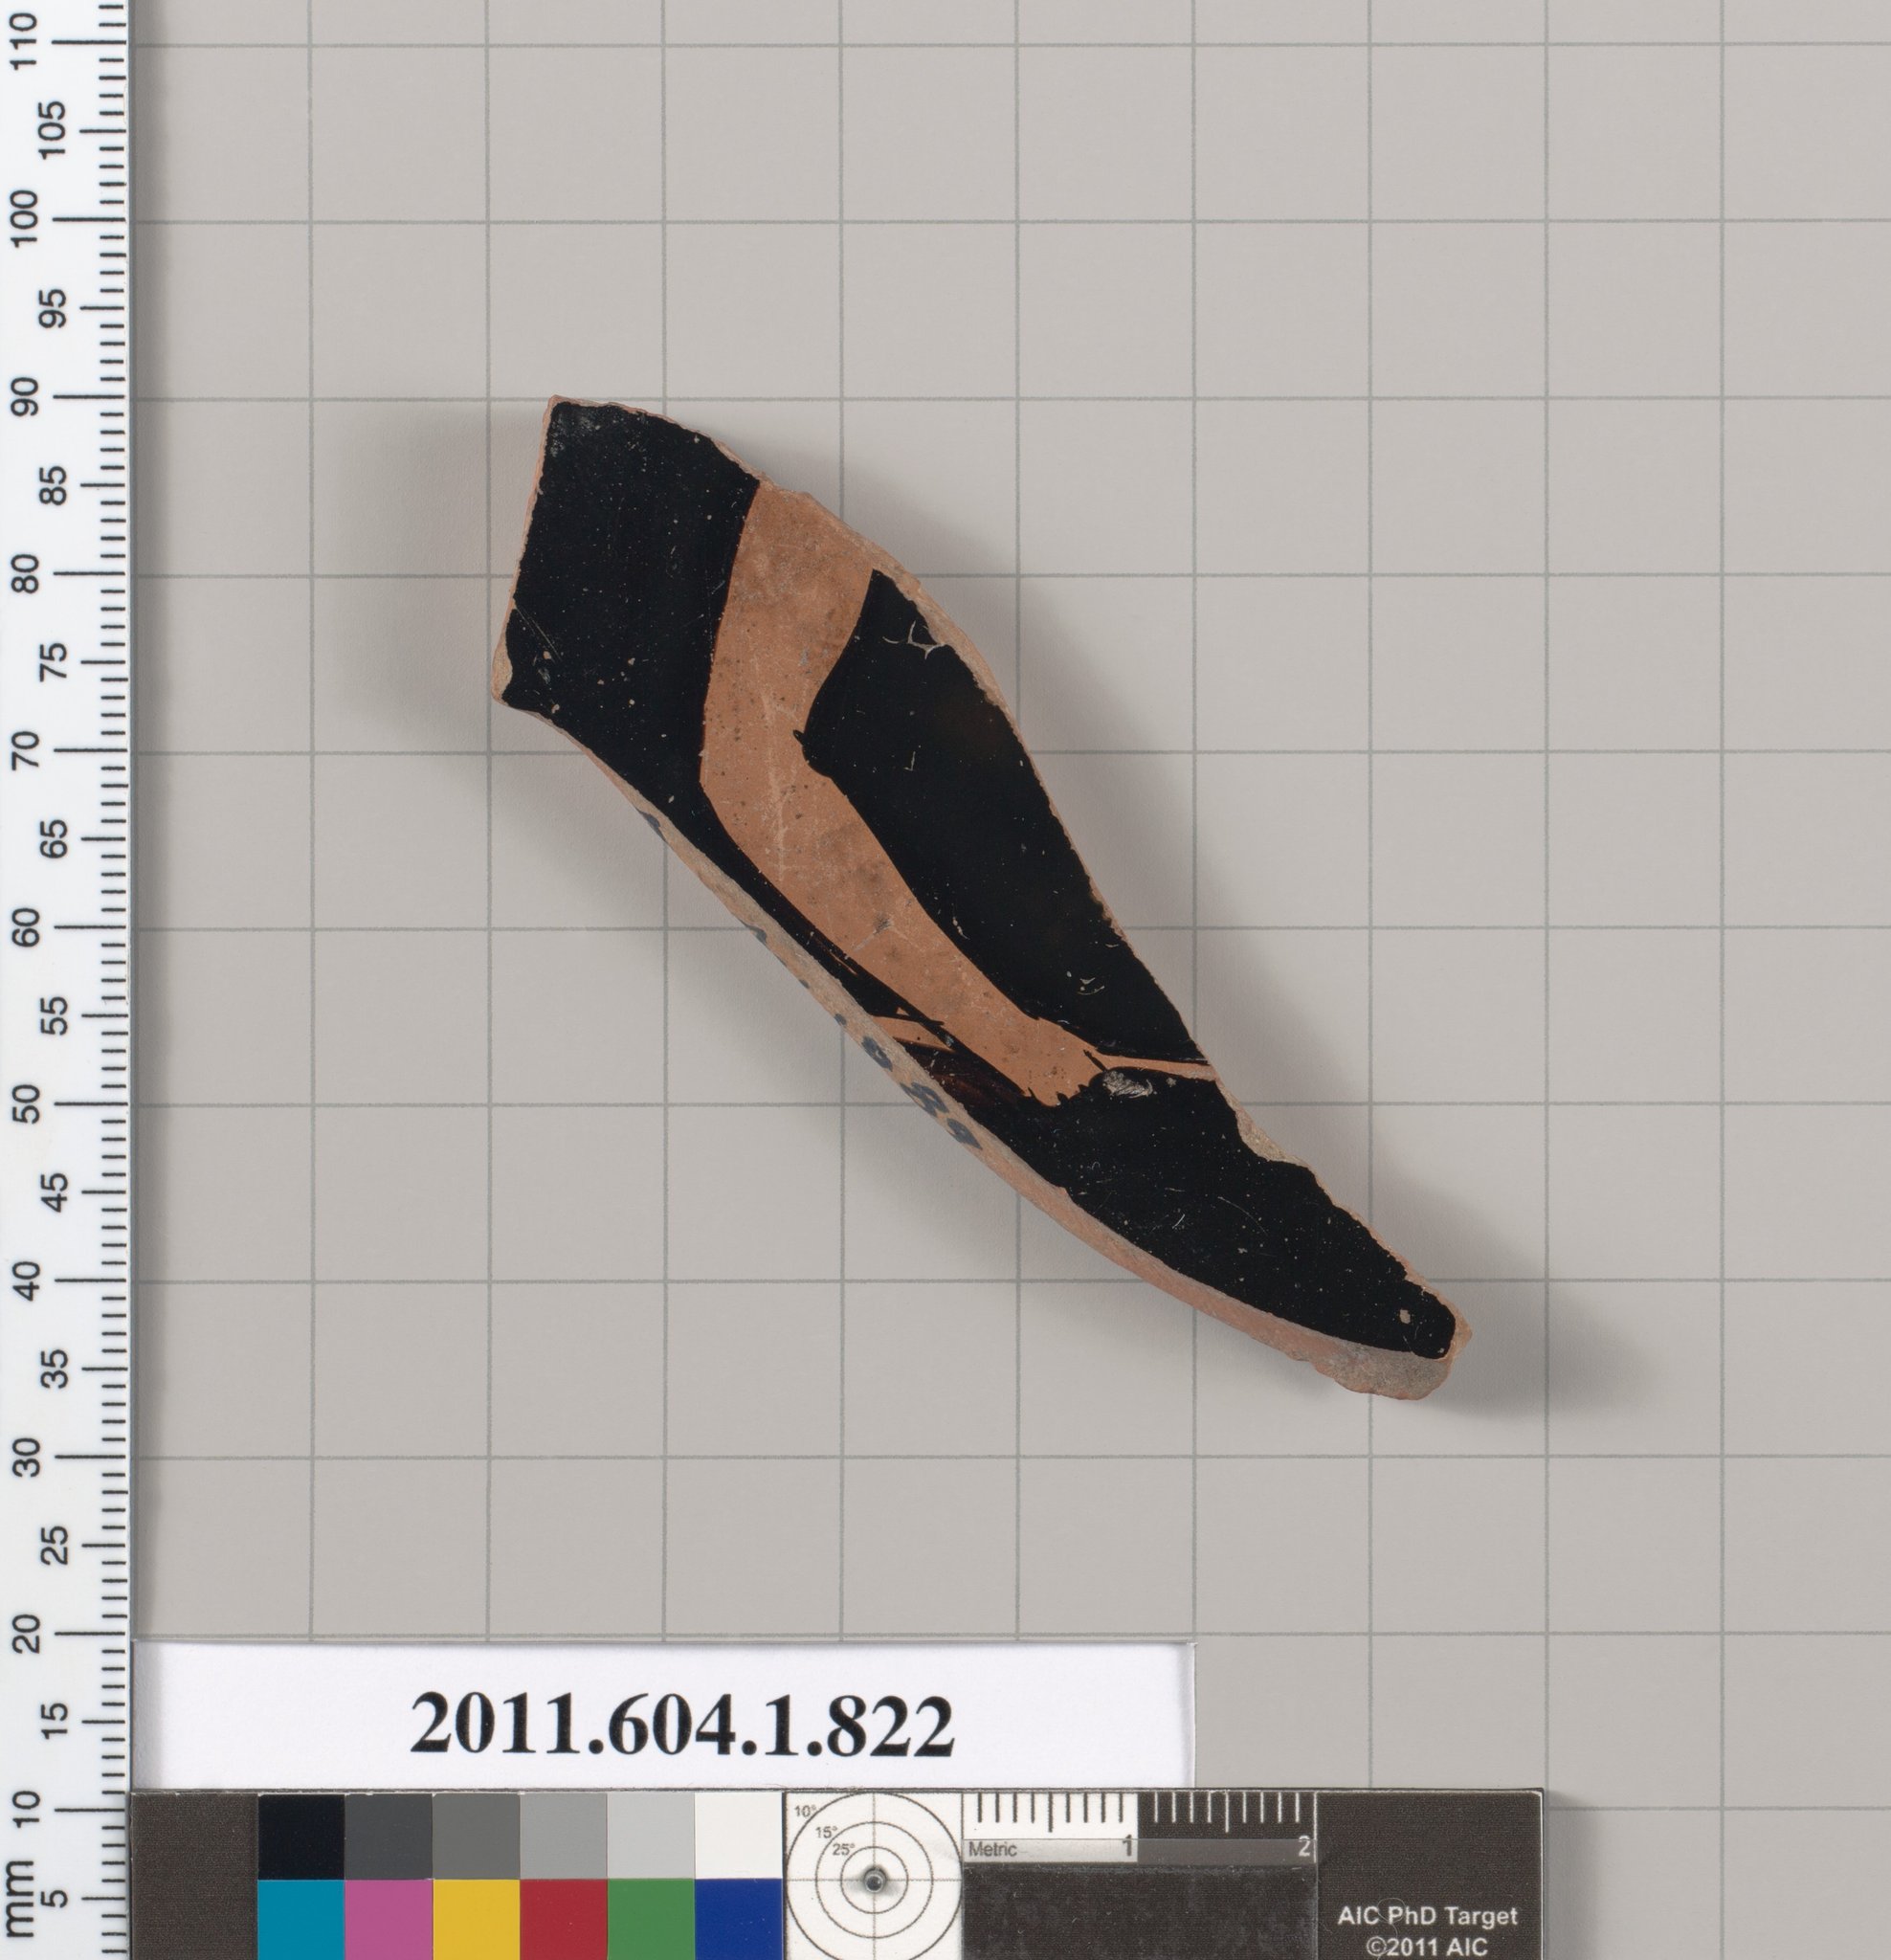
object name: kylix fragment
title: Terracotta fragment of a kylix (drinking cup)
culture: greek, attic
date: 475-451 BCE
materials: terracotta